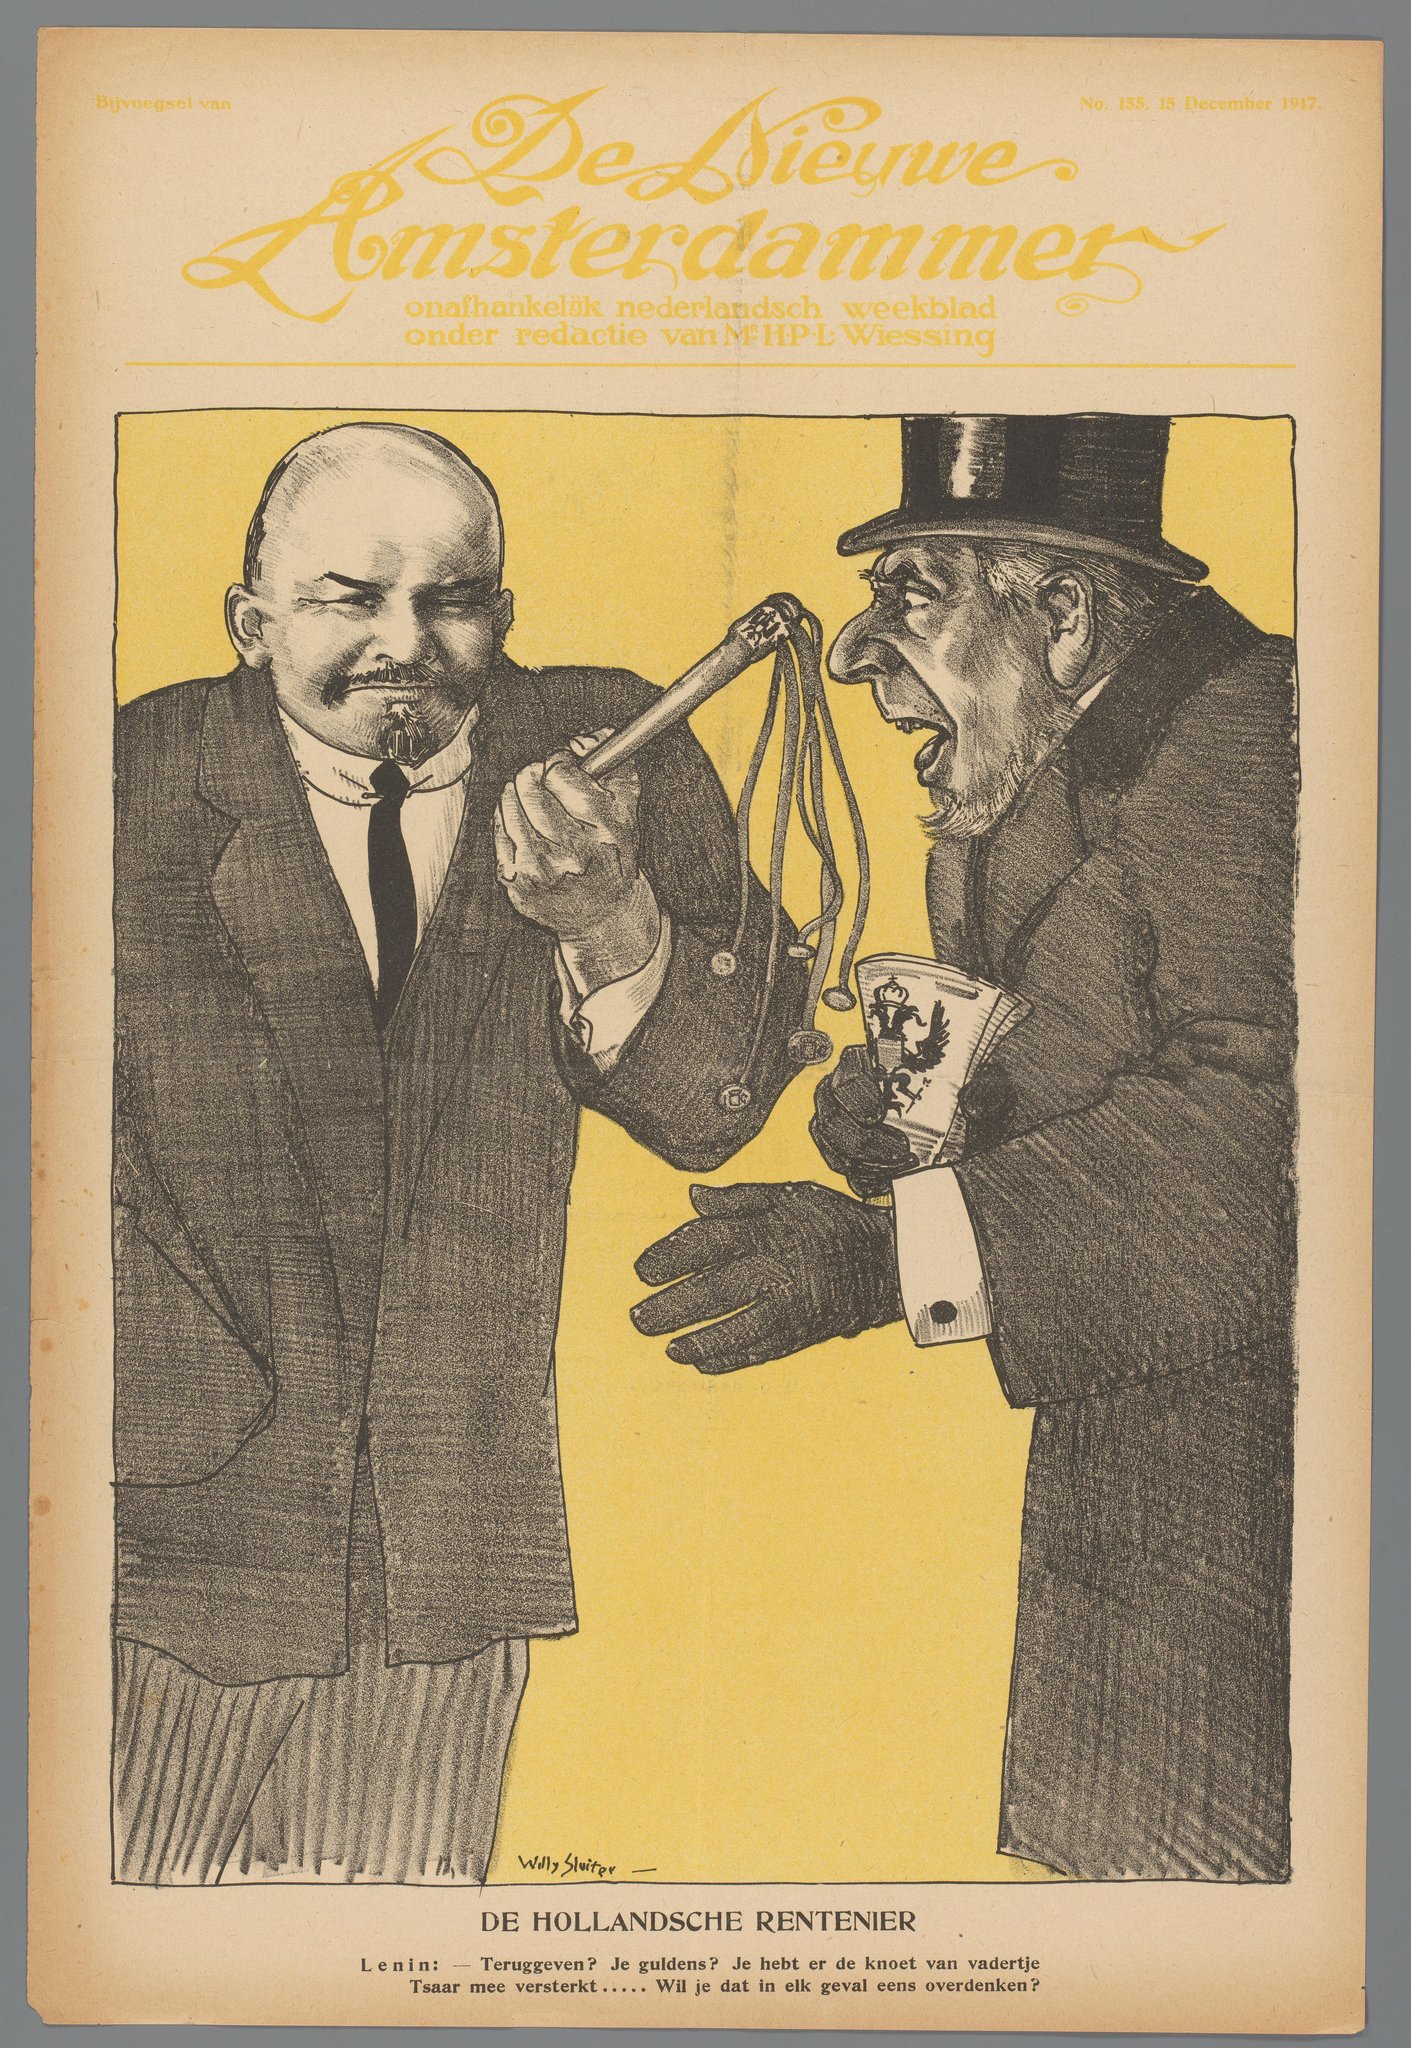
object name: cartoon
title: De Hollandsche rentenier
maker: willy sluiter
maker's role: draughtsman, painter, print maker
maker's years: 1873-1949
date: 1917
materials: paper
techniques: lithograph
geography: netherlands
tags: instruments of torture, execution or punishment: scourge, political caricatures and satires, russia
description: Lenins afwijzend antwoord op het Nederlandse verzoek om de aflossing van staatsleningen aan het tsaristische regime in Rusland. Naar aanleiding van de Russische Revolutie. Spotprent over buitenlandse politiek, 15 december 1917.